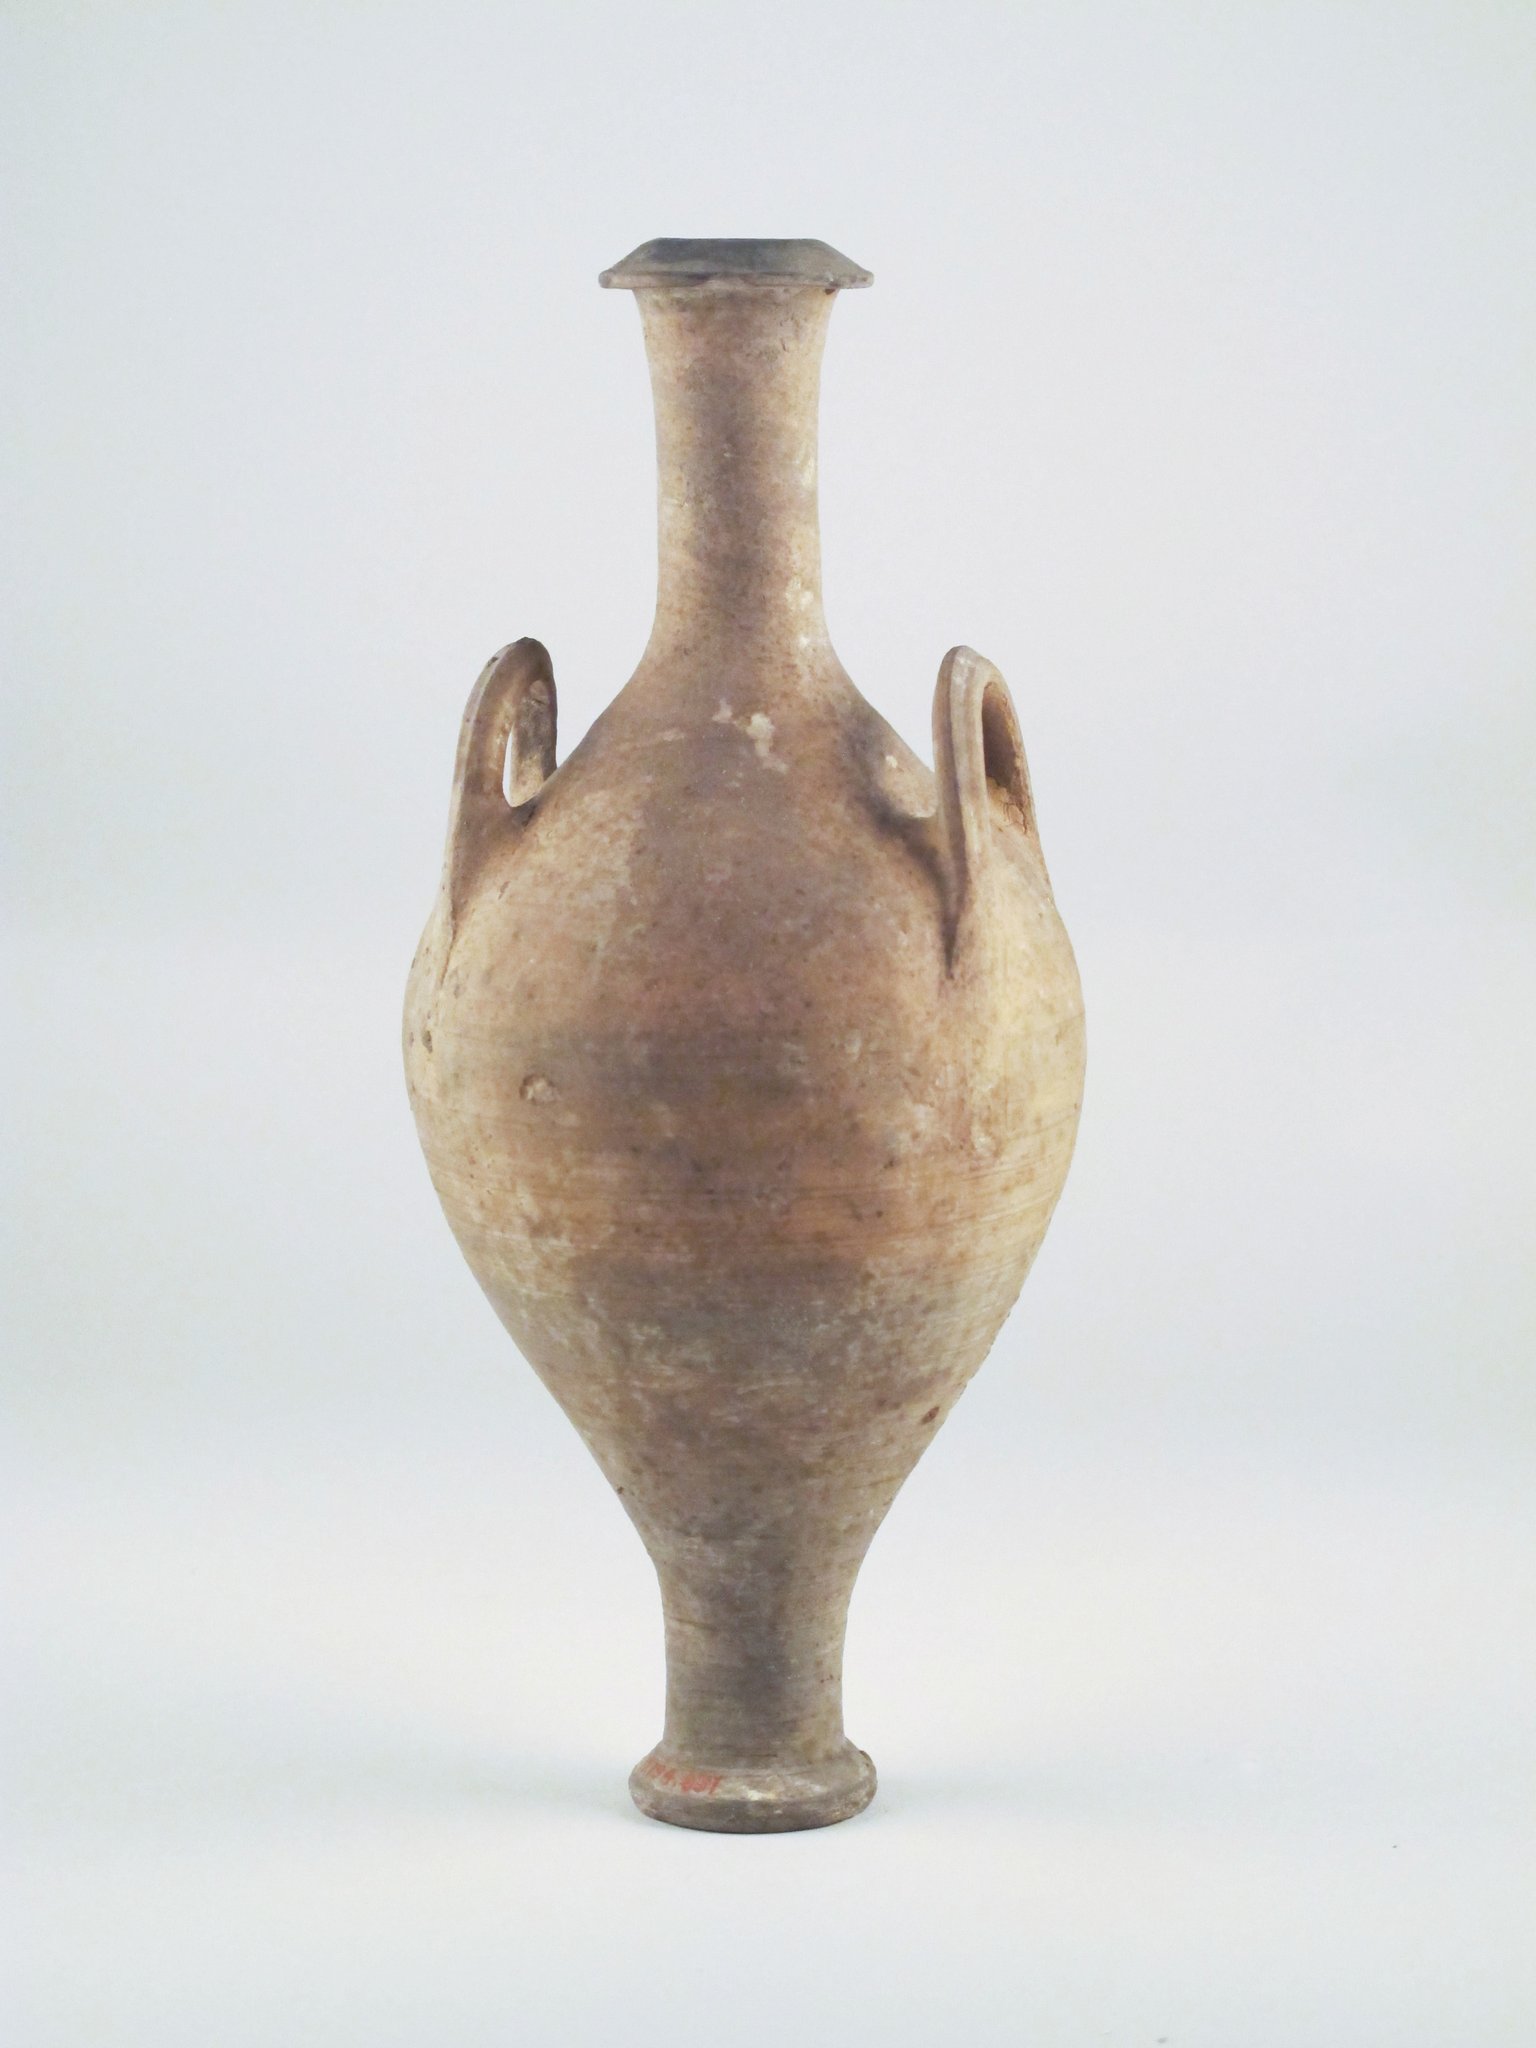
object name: vase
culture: roman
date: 670 BCE-330 CE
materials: terracotta